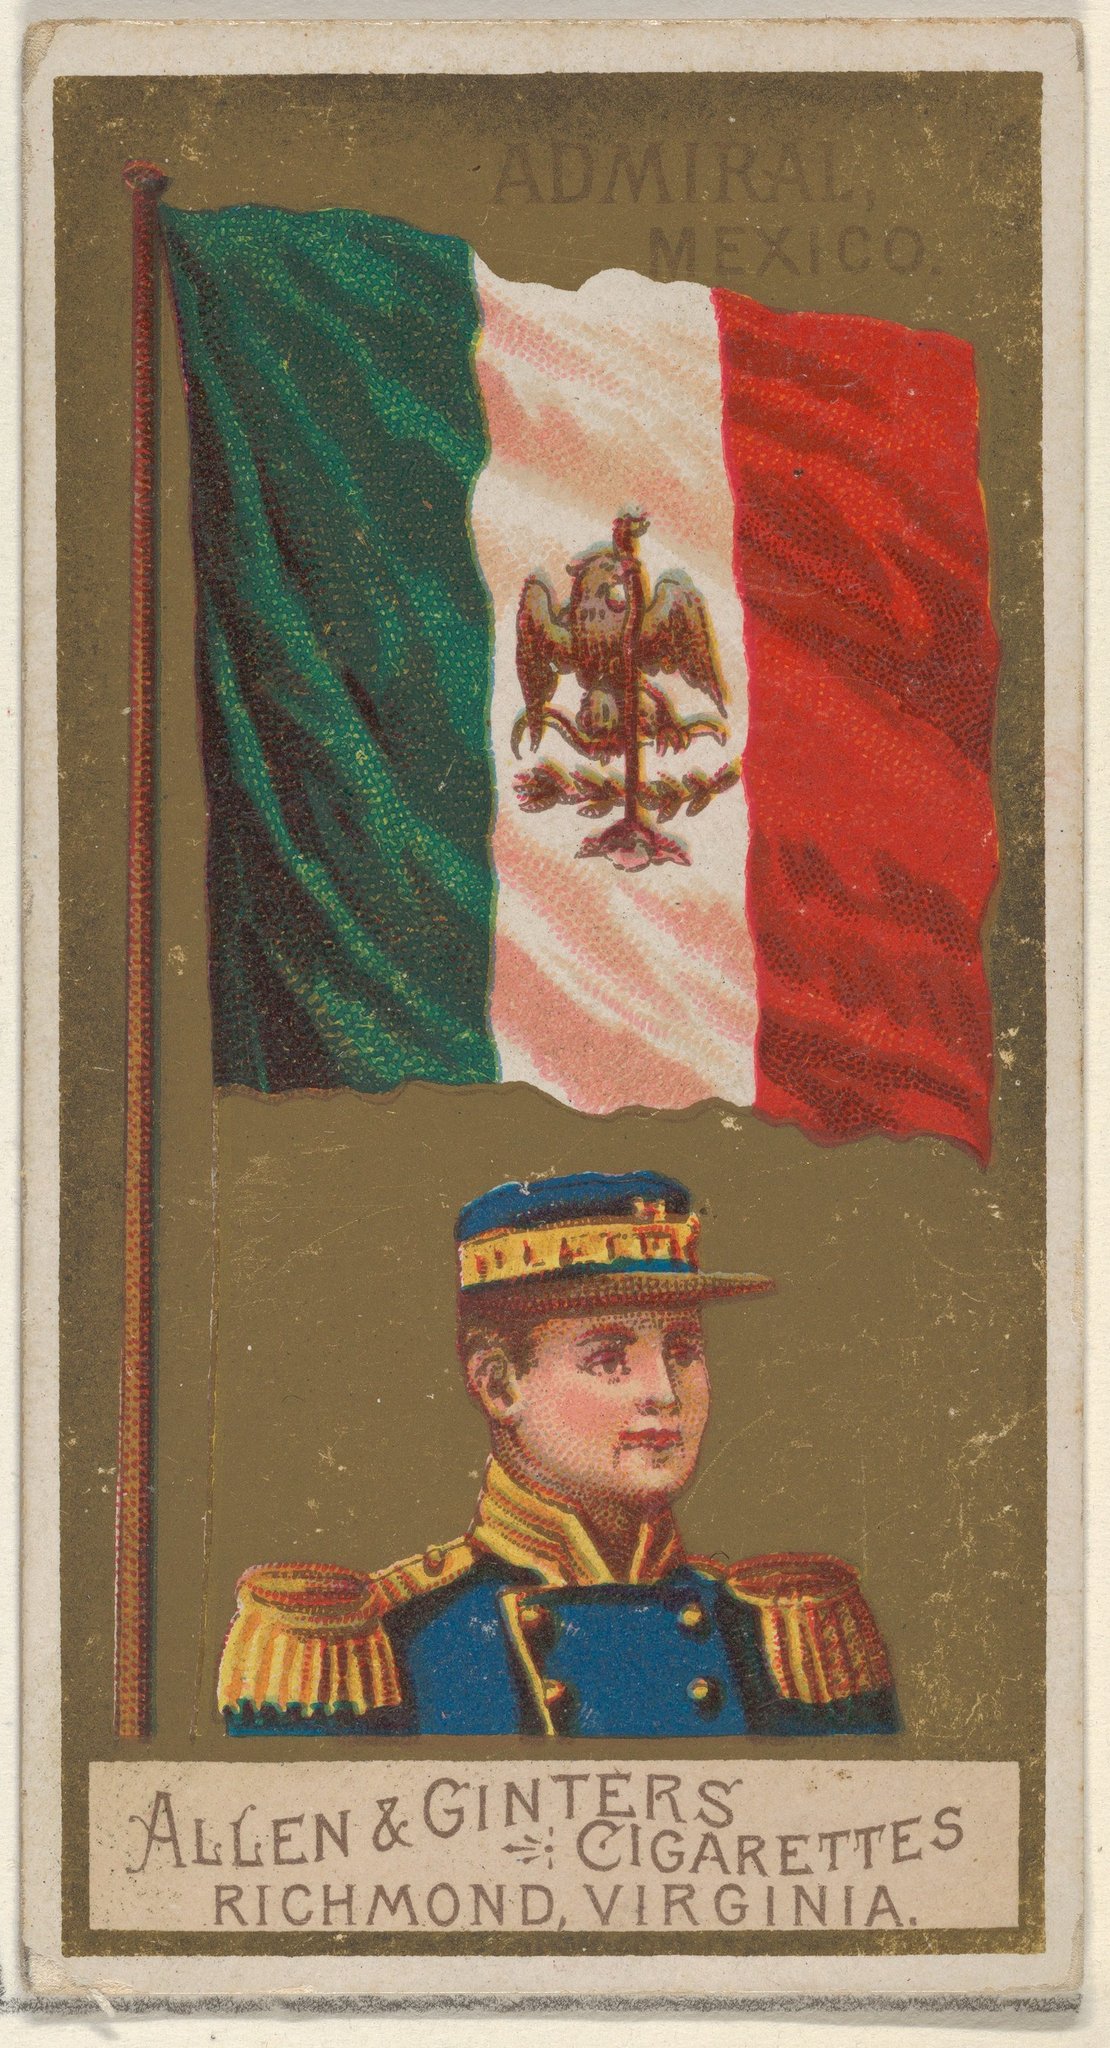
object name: print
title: Admiral, Mexico, from the Naval Flags series (N17) for Allen & Ginter Cigarettes Brands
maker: allen & ginter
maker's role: publisher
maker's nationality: american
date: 1888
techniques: color lithograph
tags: men,flags,admirals